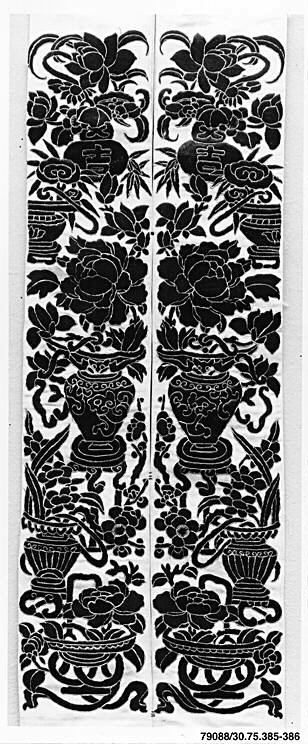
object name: sleeve band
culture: chinese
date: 1801-1900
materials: metal thread, silk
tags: flowers